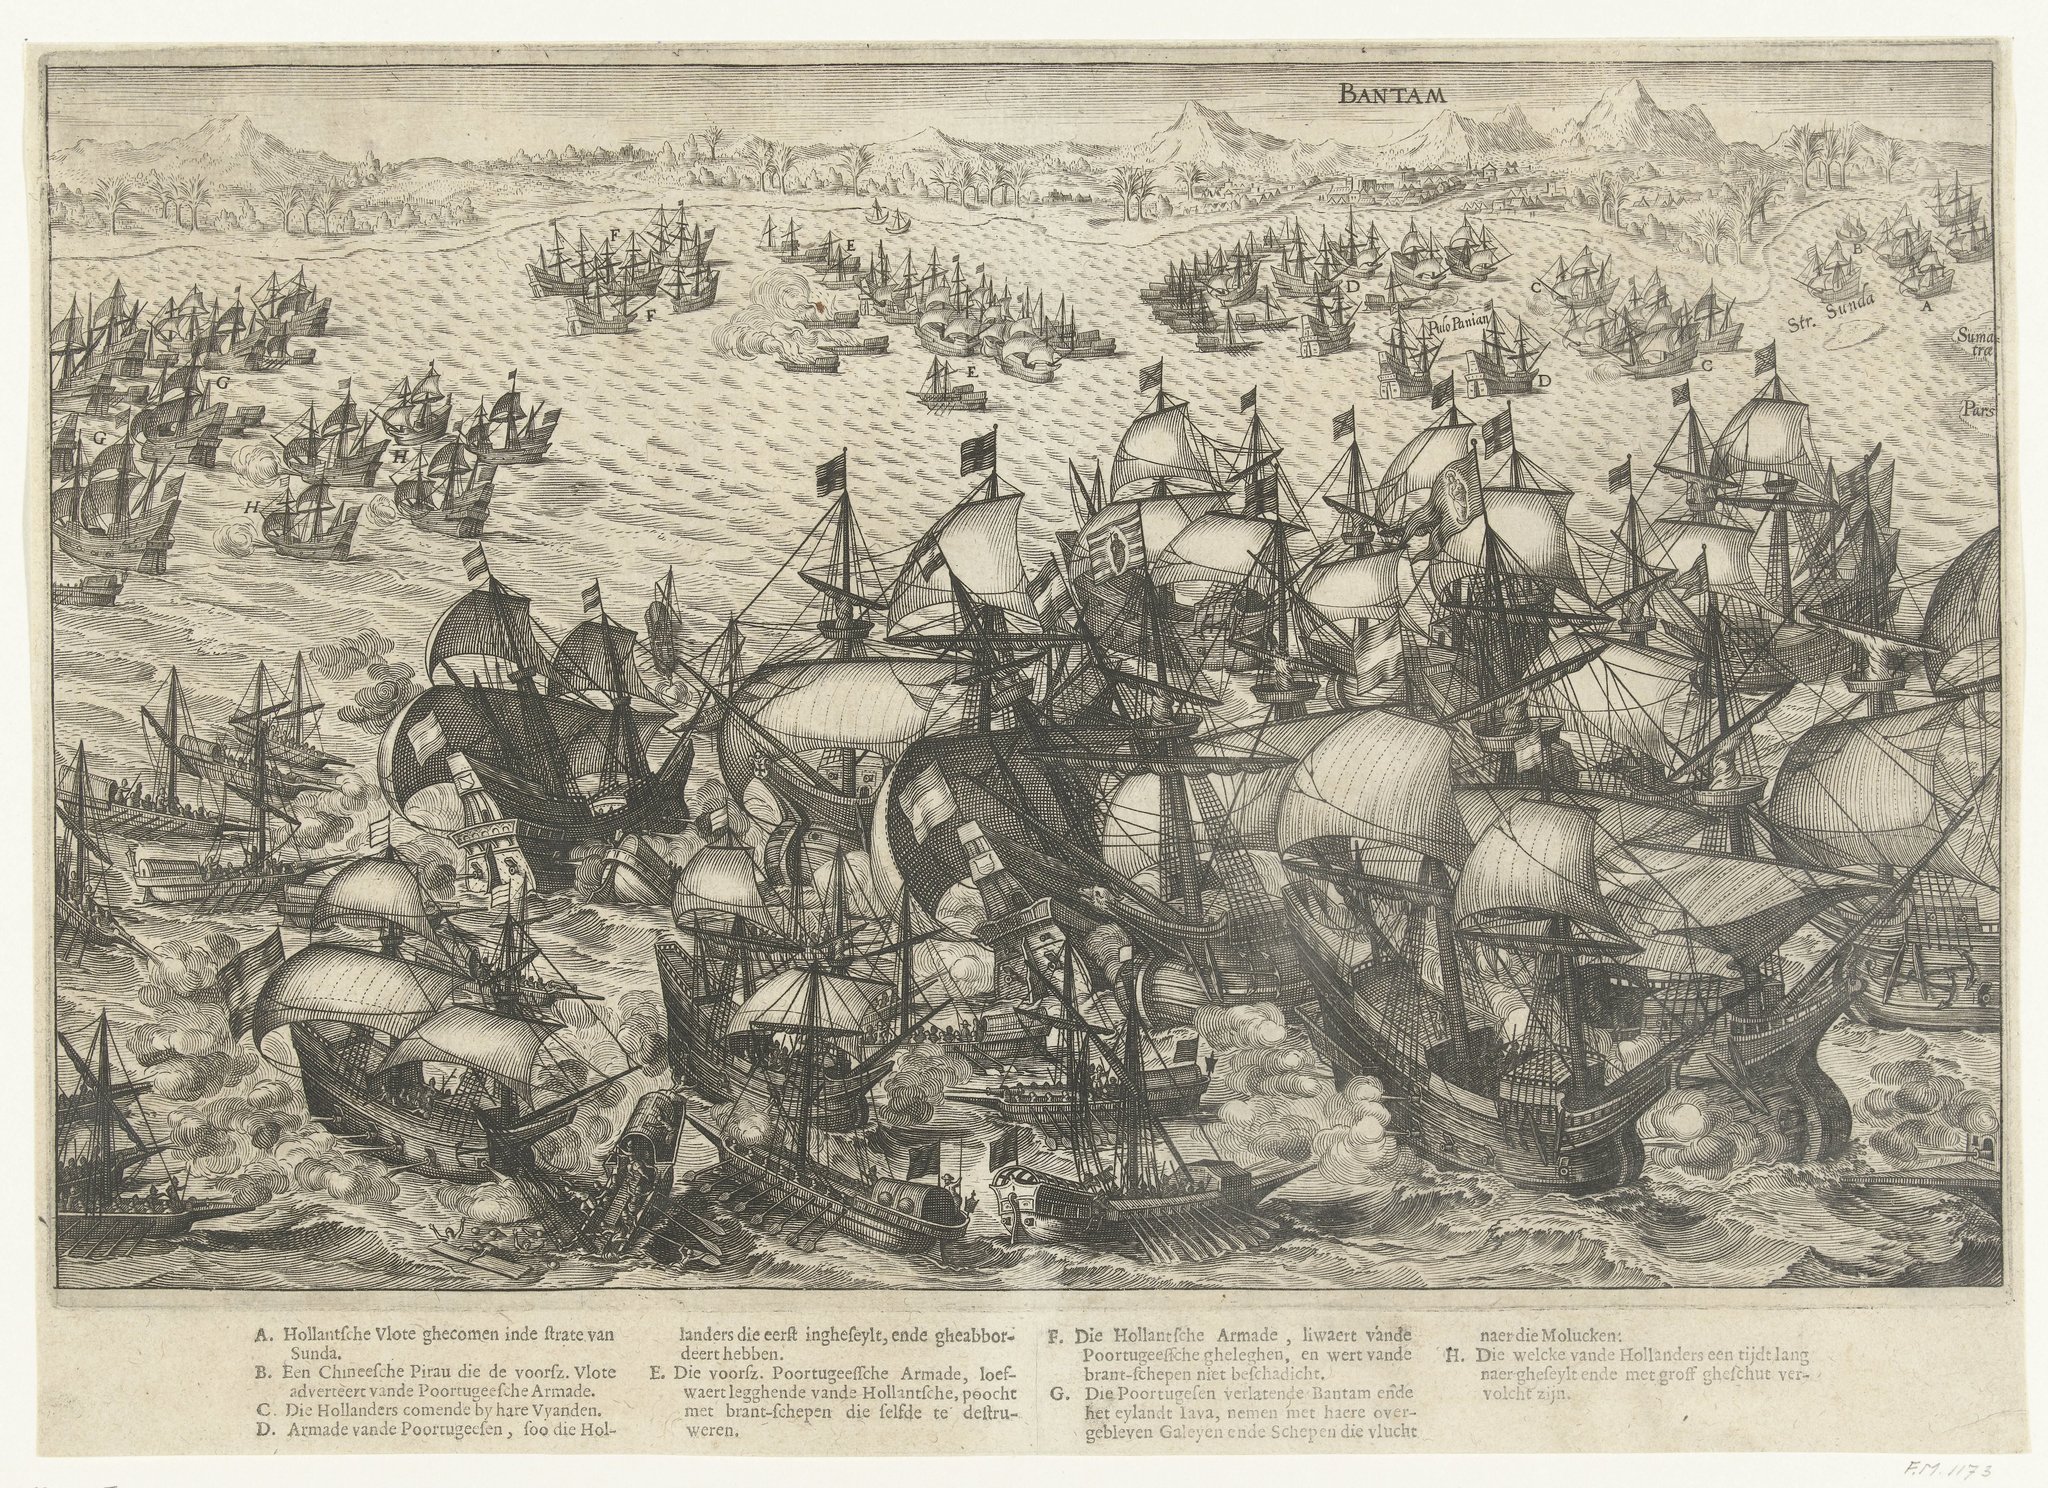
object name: print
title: Overwinning op de Portugese vloot voor Bantam, 1601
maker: bartholomeus willemsz. dolendo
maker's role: print maker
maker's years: 1560-1626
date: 1601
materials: paper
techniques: engraving, letterpress printing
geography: northern netherlands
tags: battle (+ naval force)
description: Gebruikt als illustratie in: J.J. Orlers, Den Nassauschen Lauren-Crans: Beschrijvinghe ende af-beeldinge van alle de victorien ... die Godt Almachtich de ... Staten der Vereenichde Nederlanden verleent heeft, deur het wijs ende clouck beleyt des Hooch-ghebooren Fursts Maurits van Nassau, J.J. Orlers en H. van Haestens, Leiden 1610, fol. 166/167. Naar de anonieme prent met dezelfde voorstelling (FMH 1172).